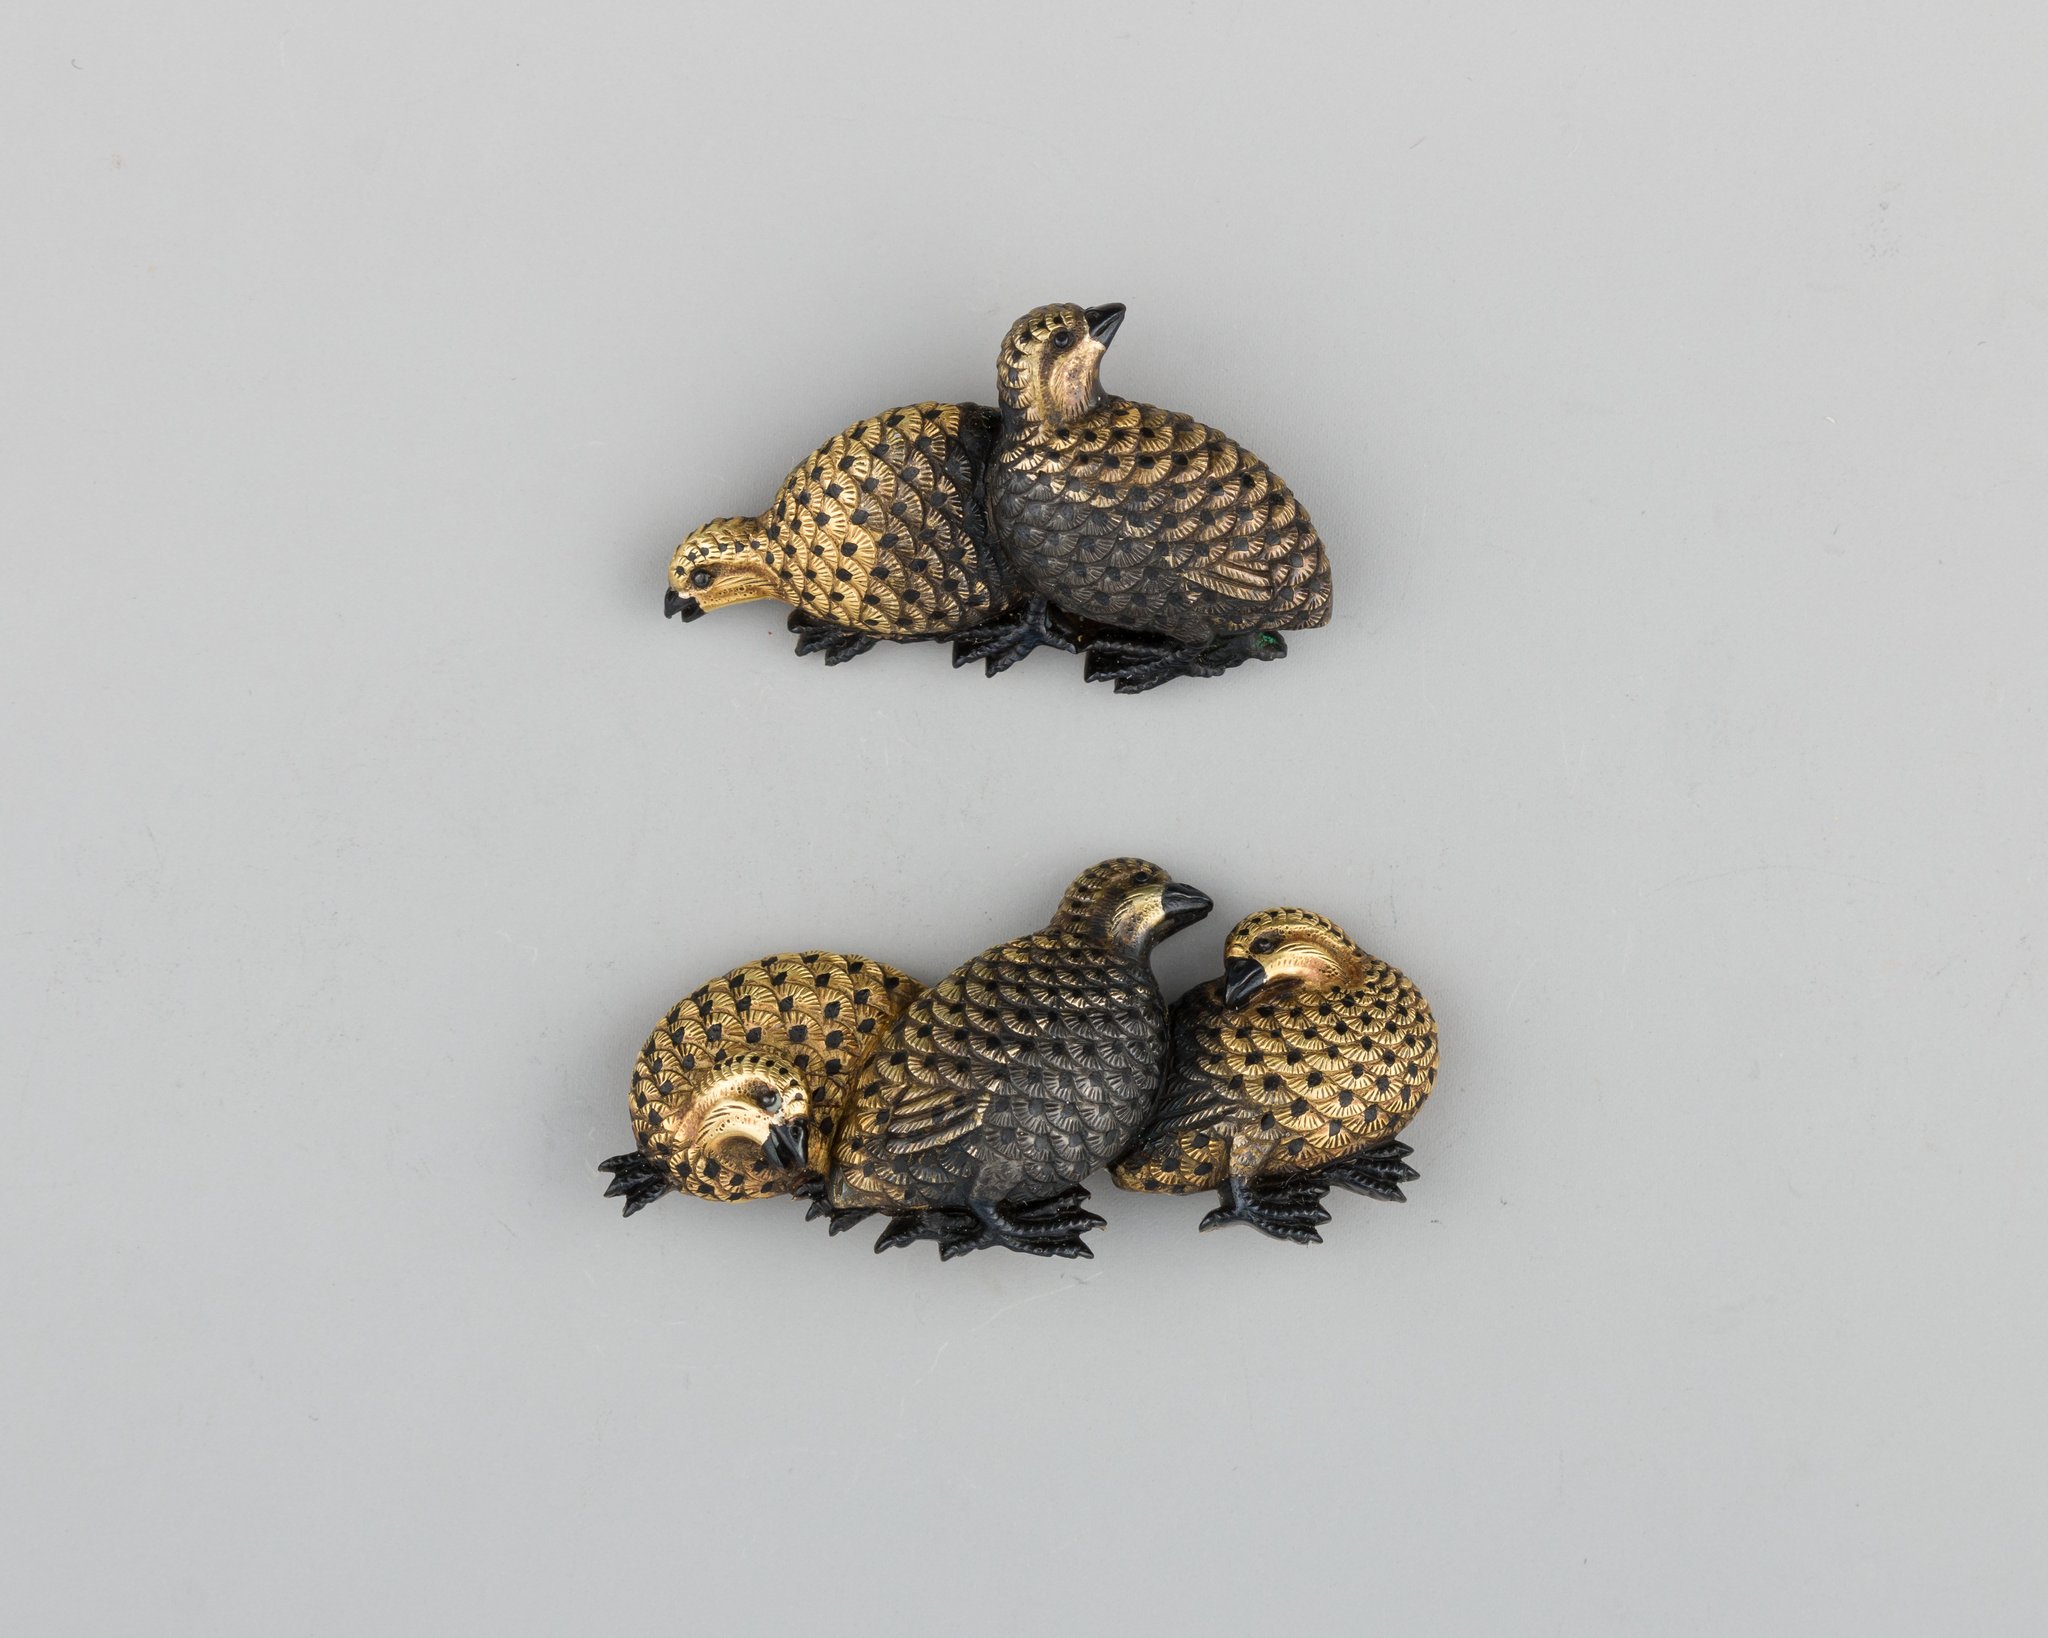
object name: pair of sword grip ornament menuki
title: Pair of Sword-Grip Ornaments (Menuki)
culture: japanese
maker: osozuka hisanori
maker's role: fittings maker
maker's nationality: japanese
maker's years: 1801-1900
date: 1801-1900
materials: gold alloy, gold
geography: japan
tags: birds